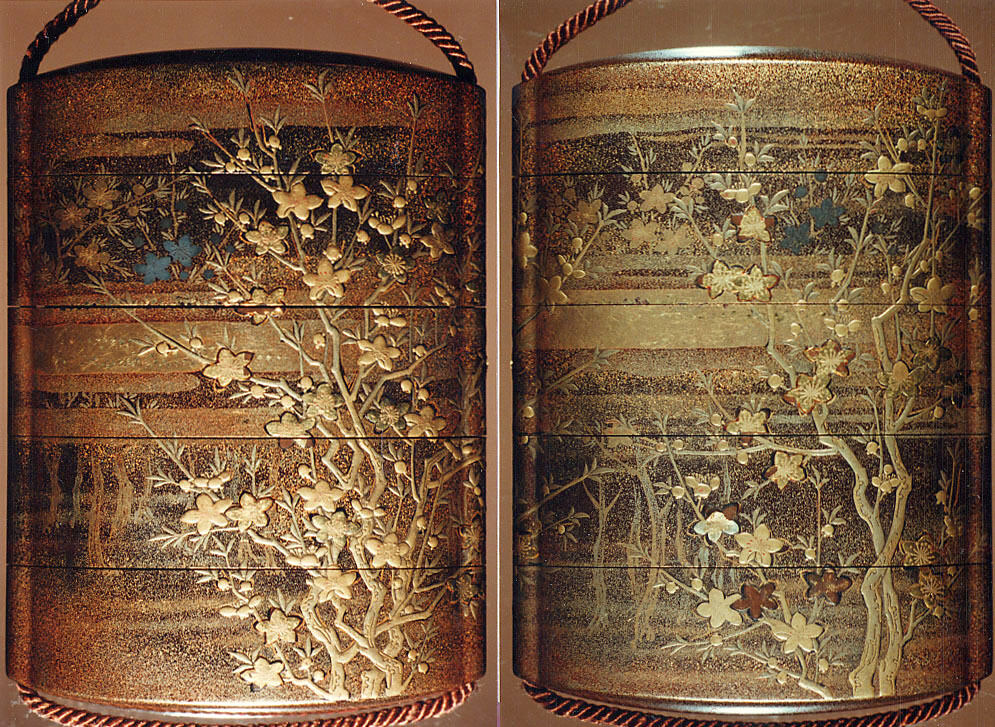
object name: inrō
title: Case (Inrō) with Design of Flowering Peach Branches with Trees and Clouds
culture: japanese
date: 1701-1900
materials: gold, lacquer, silver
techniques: fundame, hiramakie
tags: flowers,trees